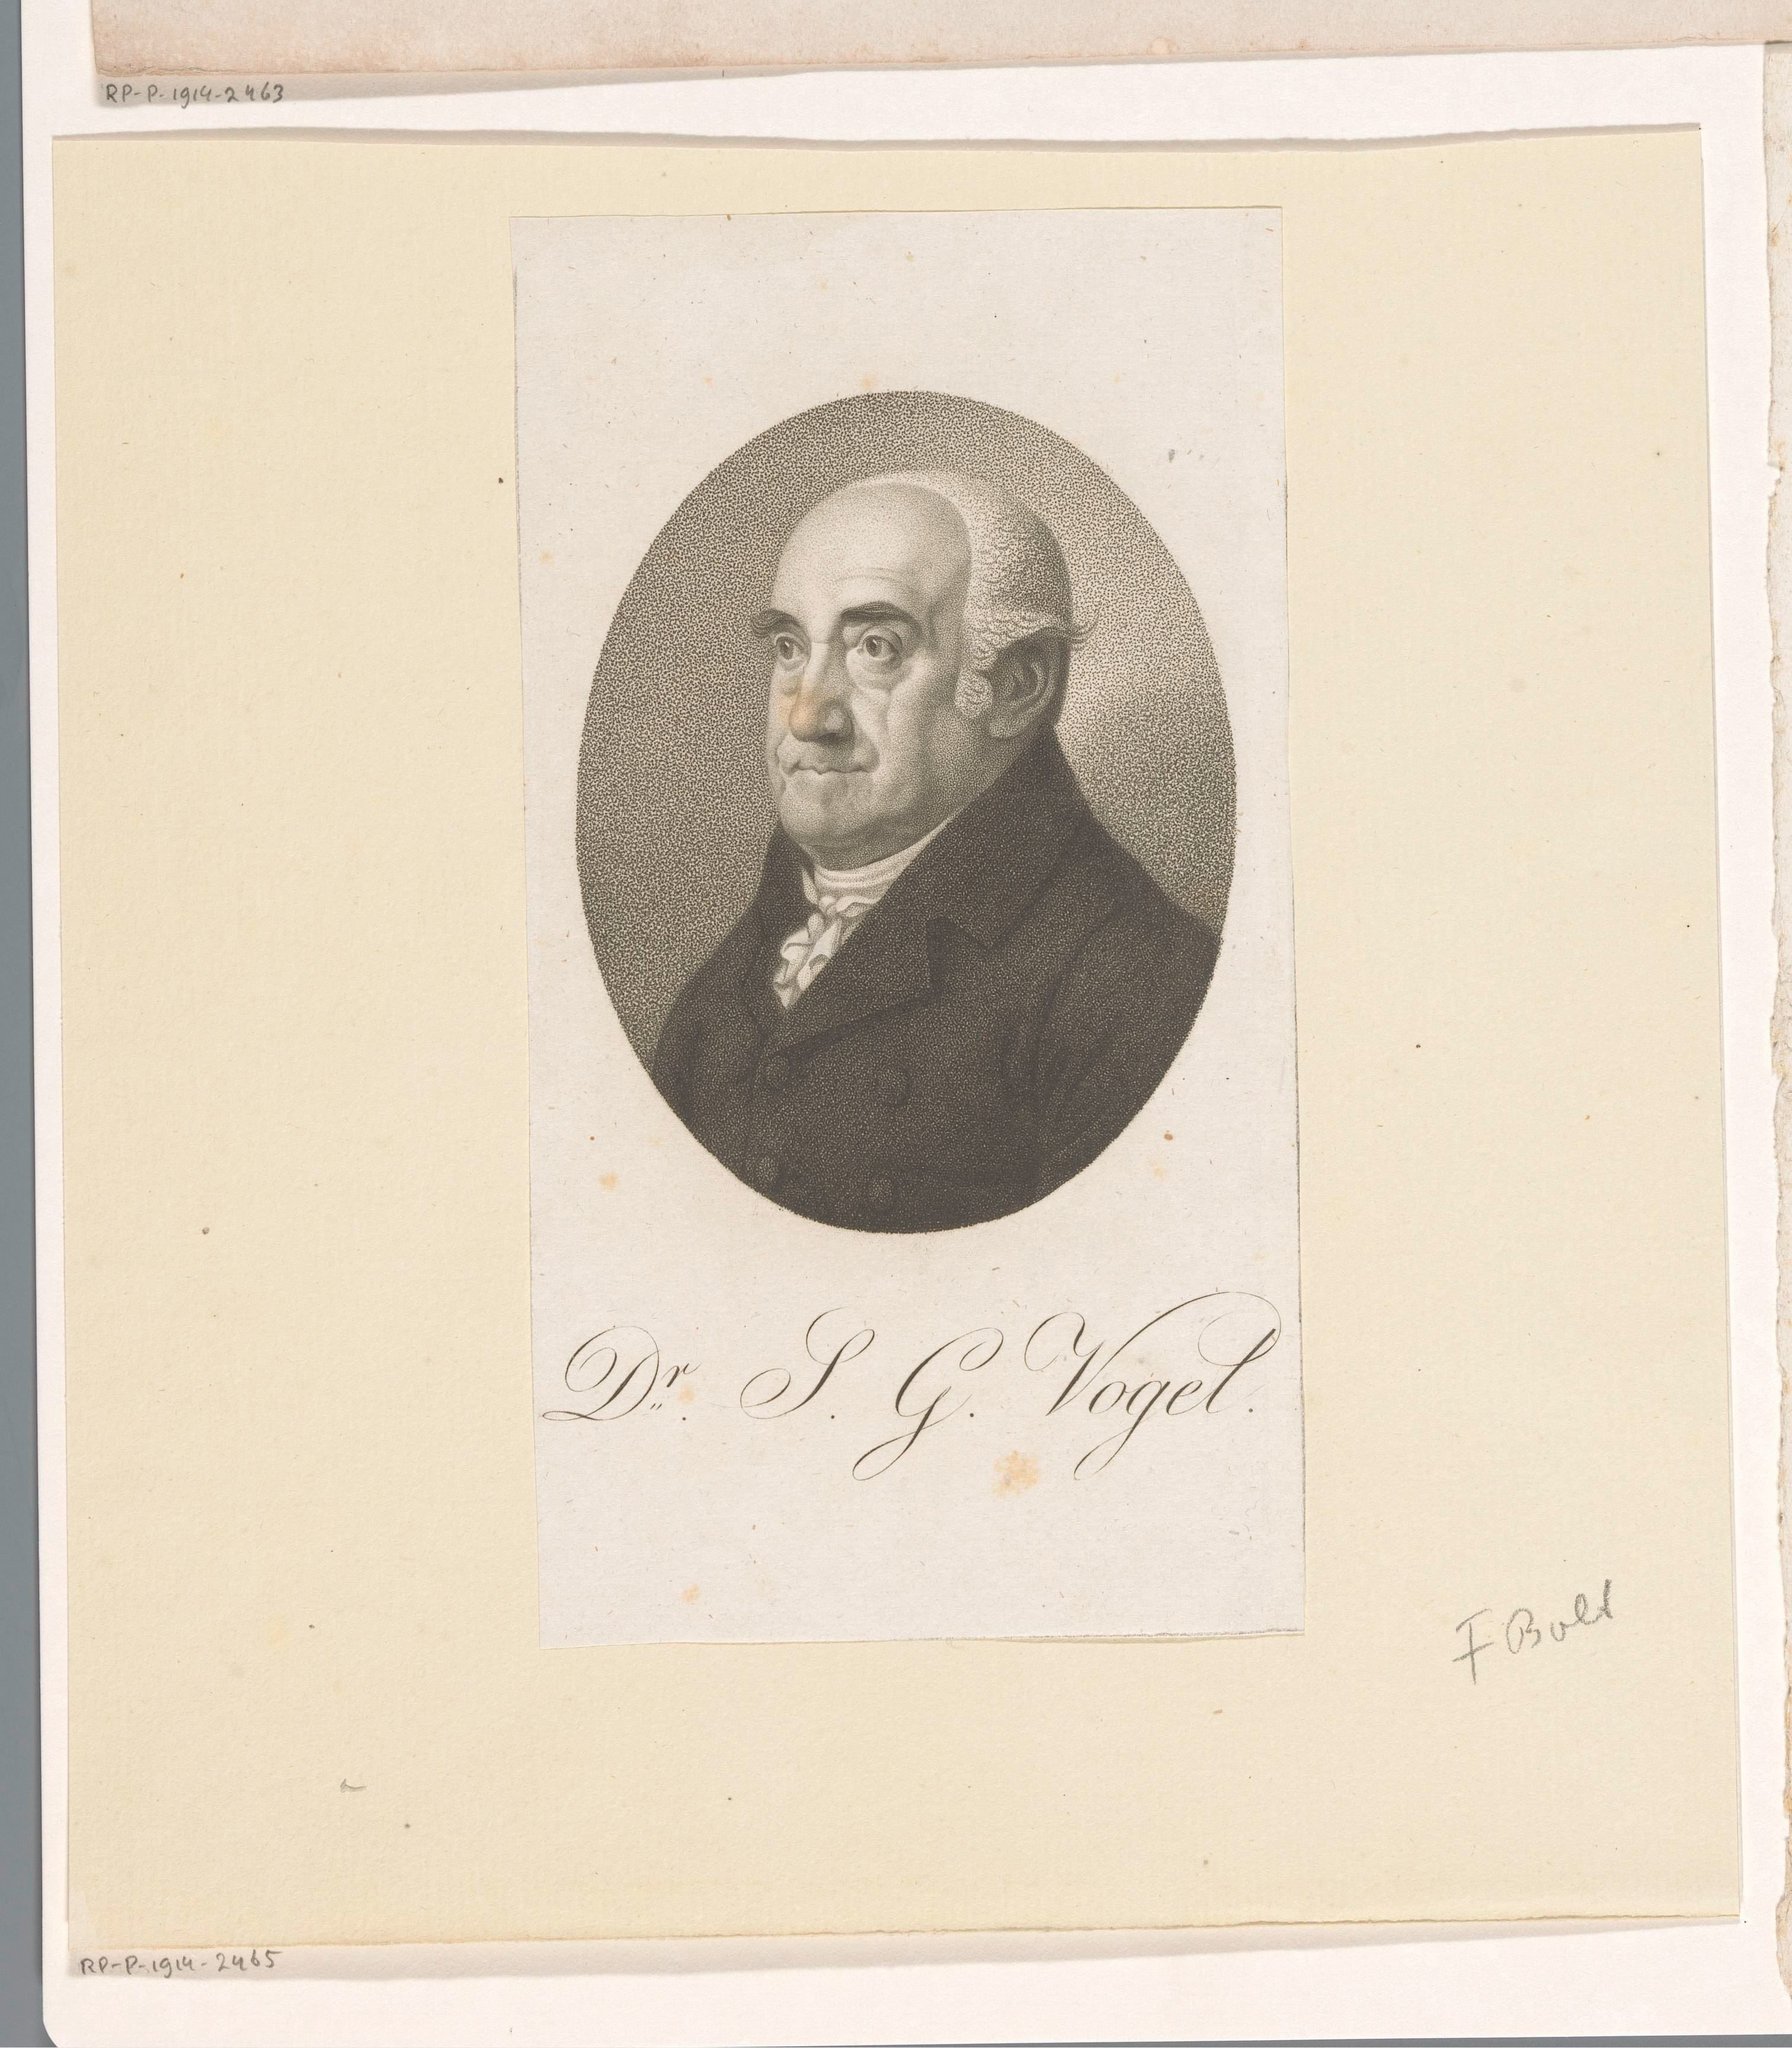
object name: print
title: Portret van Samuel Gottlieb von Vogel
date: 1789-1837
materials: paper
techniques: stippling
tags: historical persons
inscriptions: collector's mark: Lugt 2228